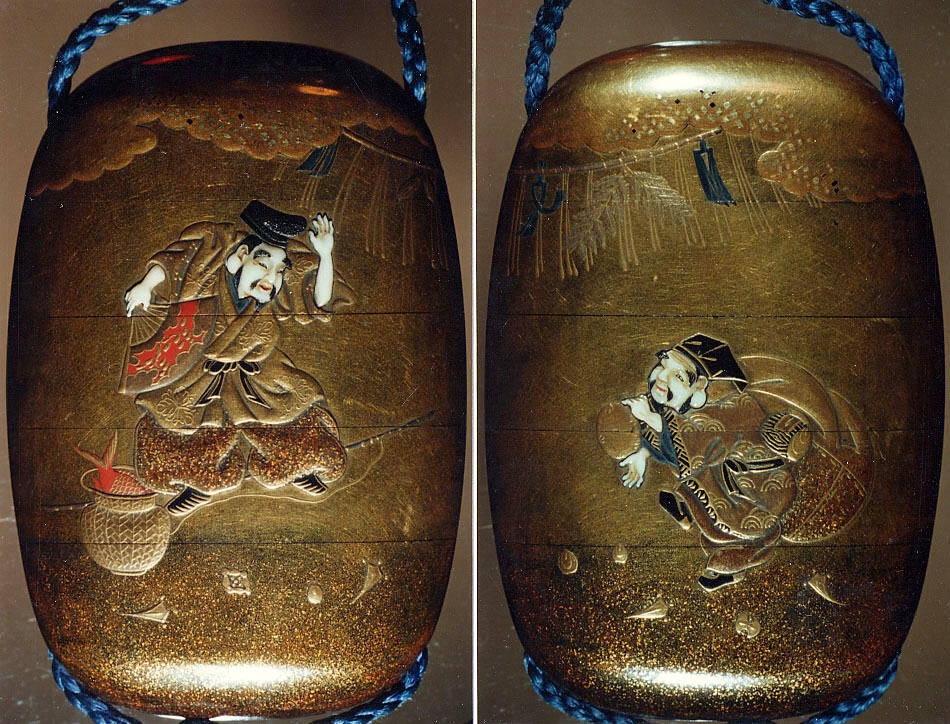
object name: inrō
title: Case (Inrō) with Design of Ebisu and Daikoku Dancing beneath New Year's Decorations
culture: japanese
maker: nikkōsai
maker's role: artist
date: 1801-1900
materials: gold, ivory, lacquer, wood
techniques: fundame, inlay, polish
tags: men,fish